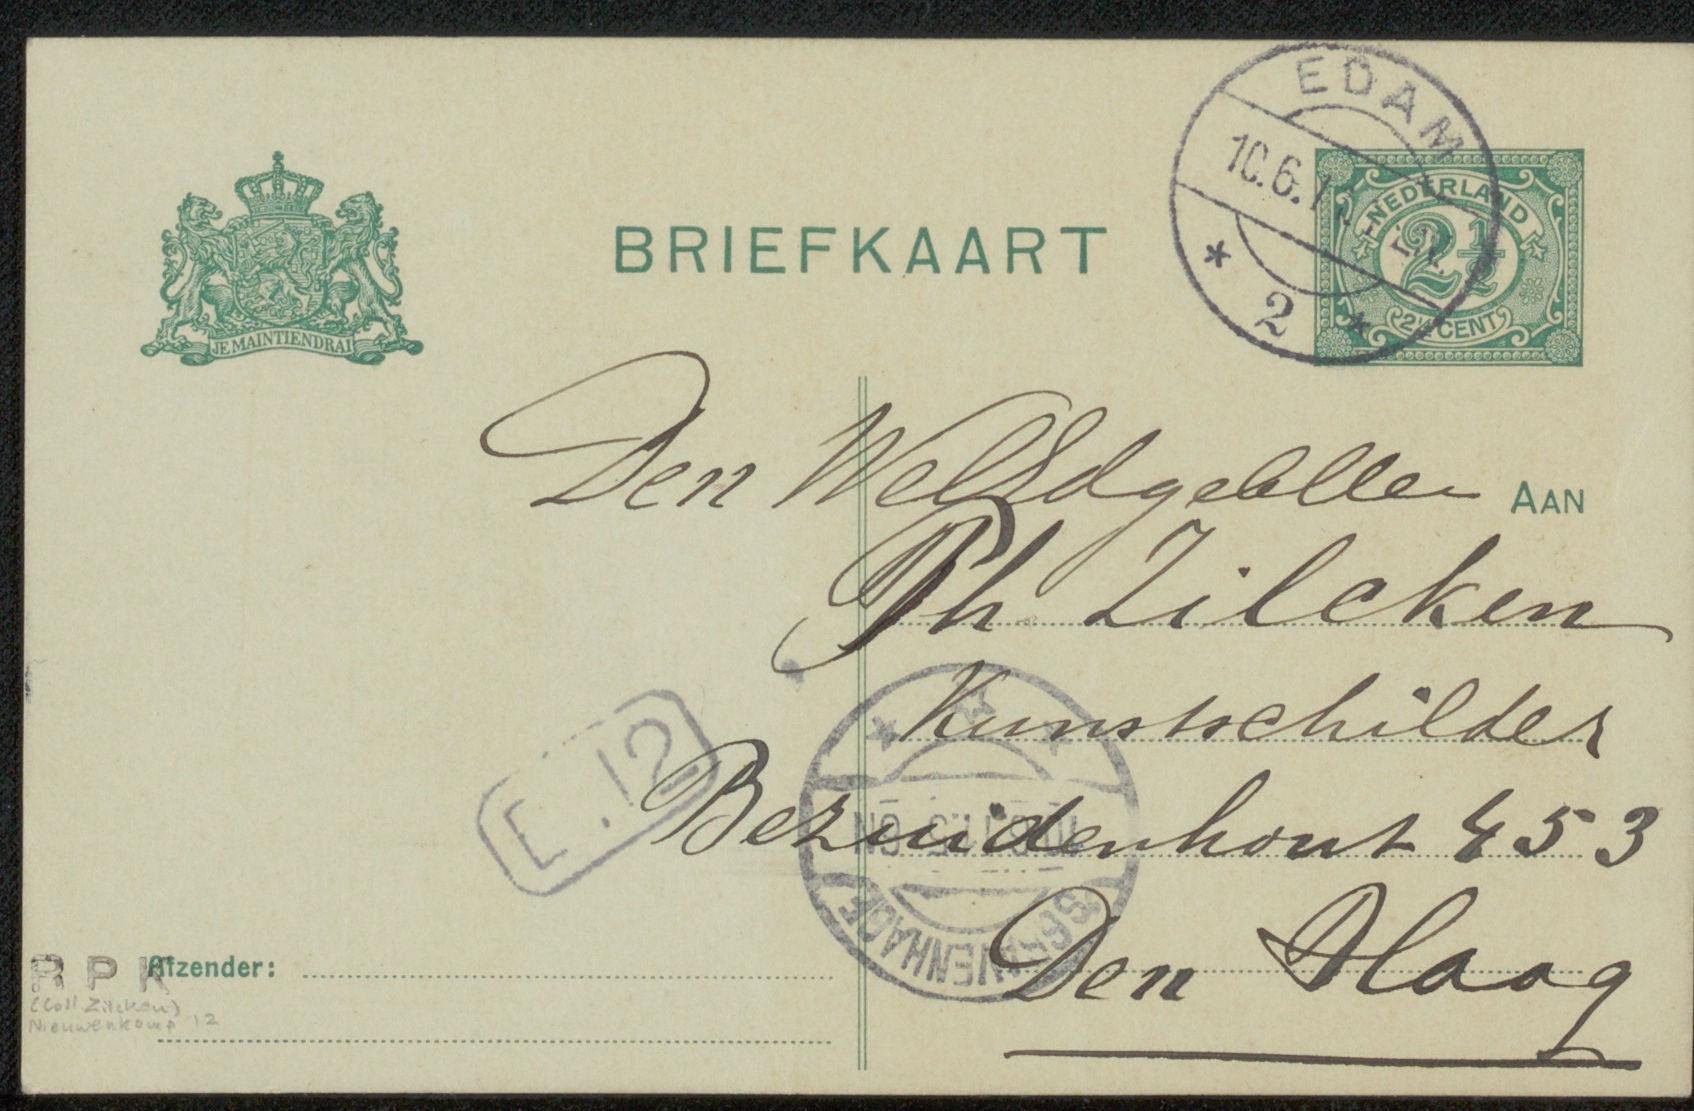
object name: postcard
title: Briefkaart aan Philip Zilcken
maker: wijnand otto jan nieuwenkamp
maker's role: draughtsman, print maker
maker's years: 1874-1950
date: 1911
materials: cardboard, ink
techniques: pen, writing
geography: edam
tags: publisher, painter, philip zilcken, drawing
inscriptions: collector's mark: ‘RPK’